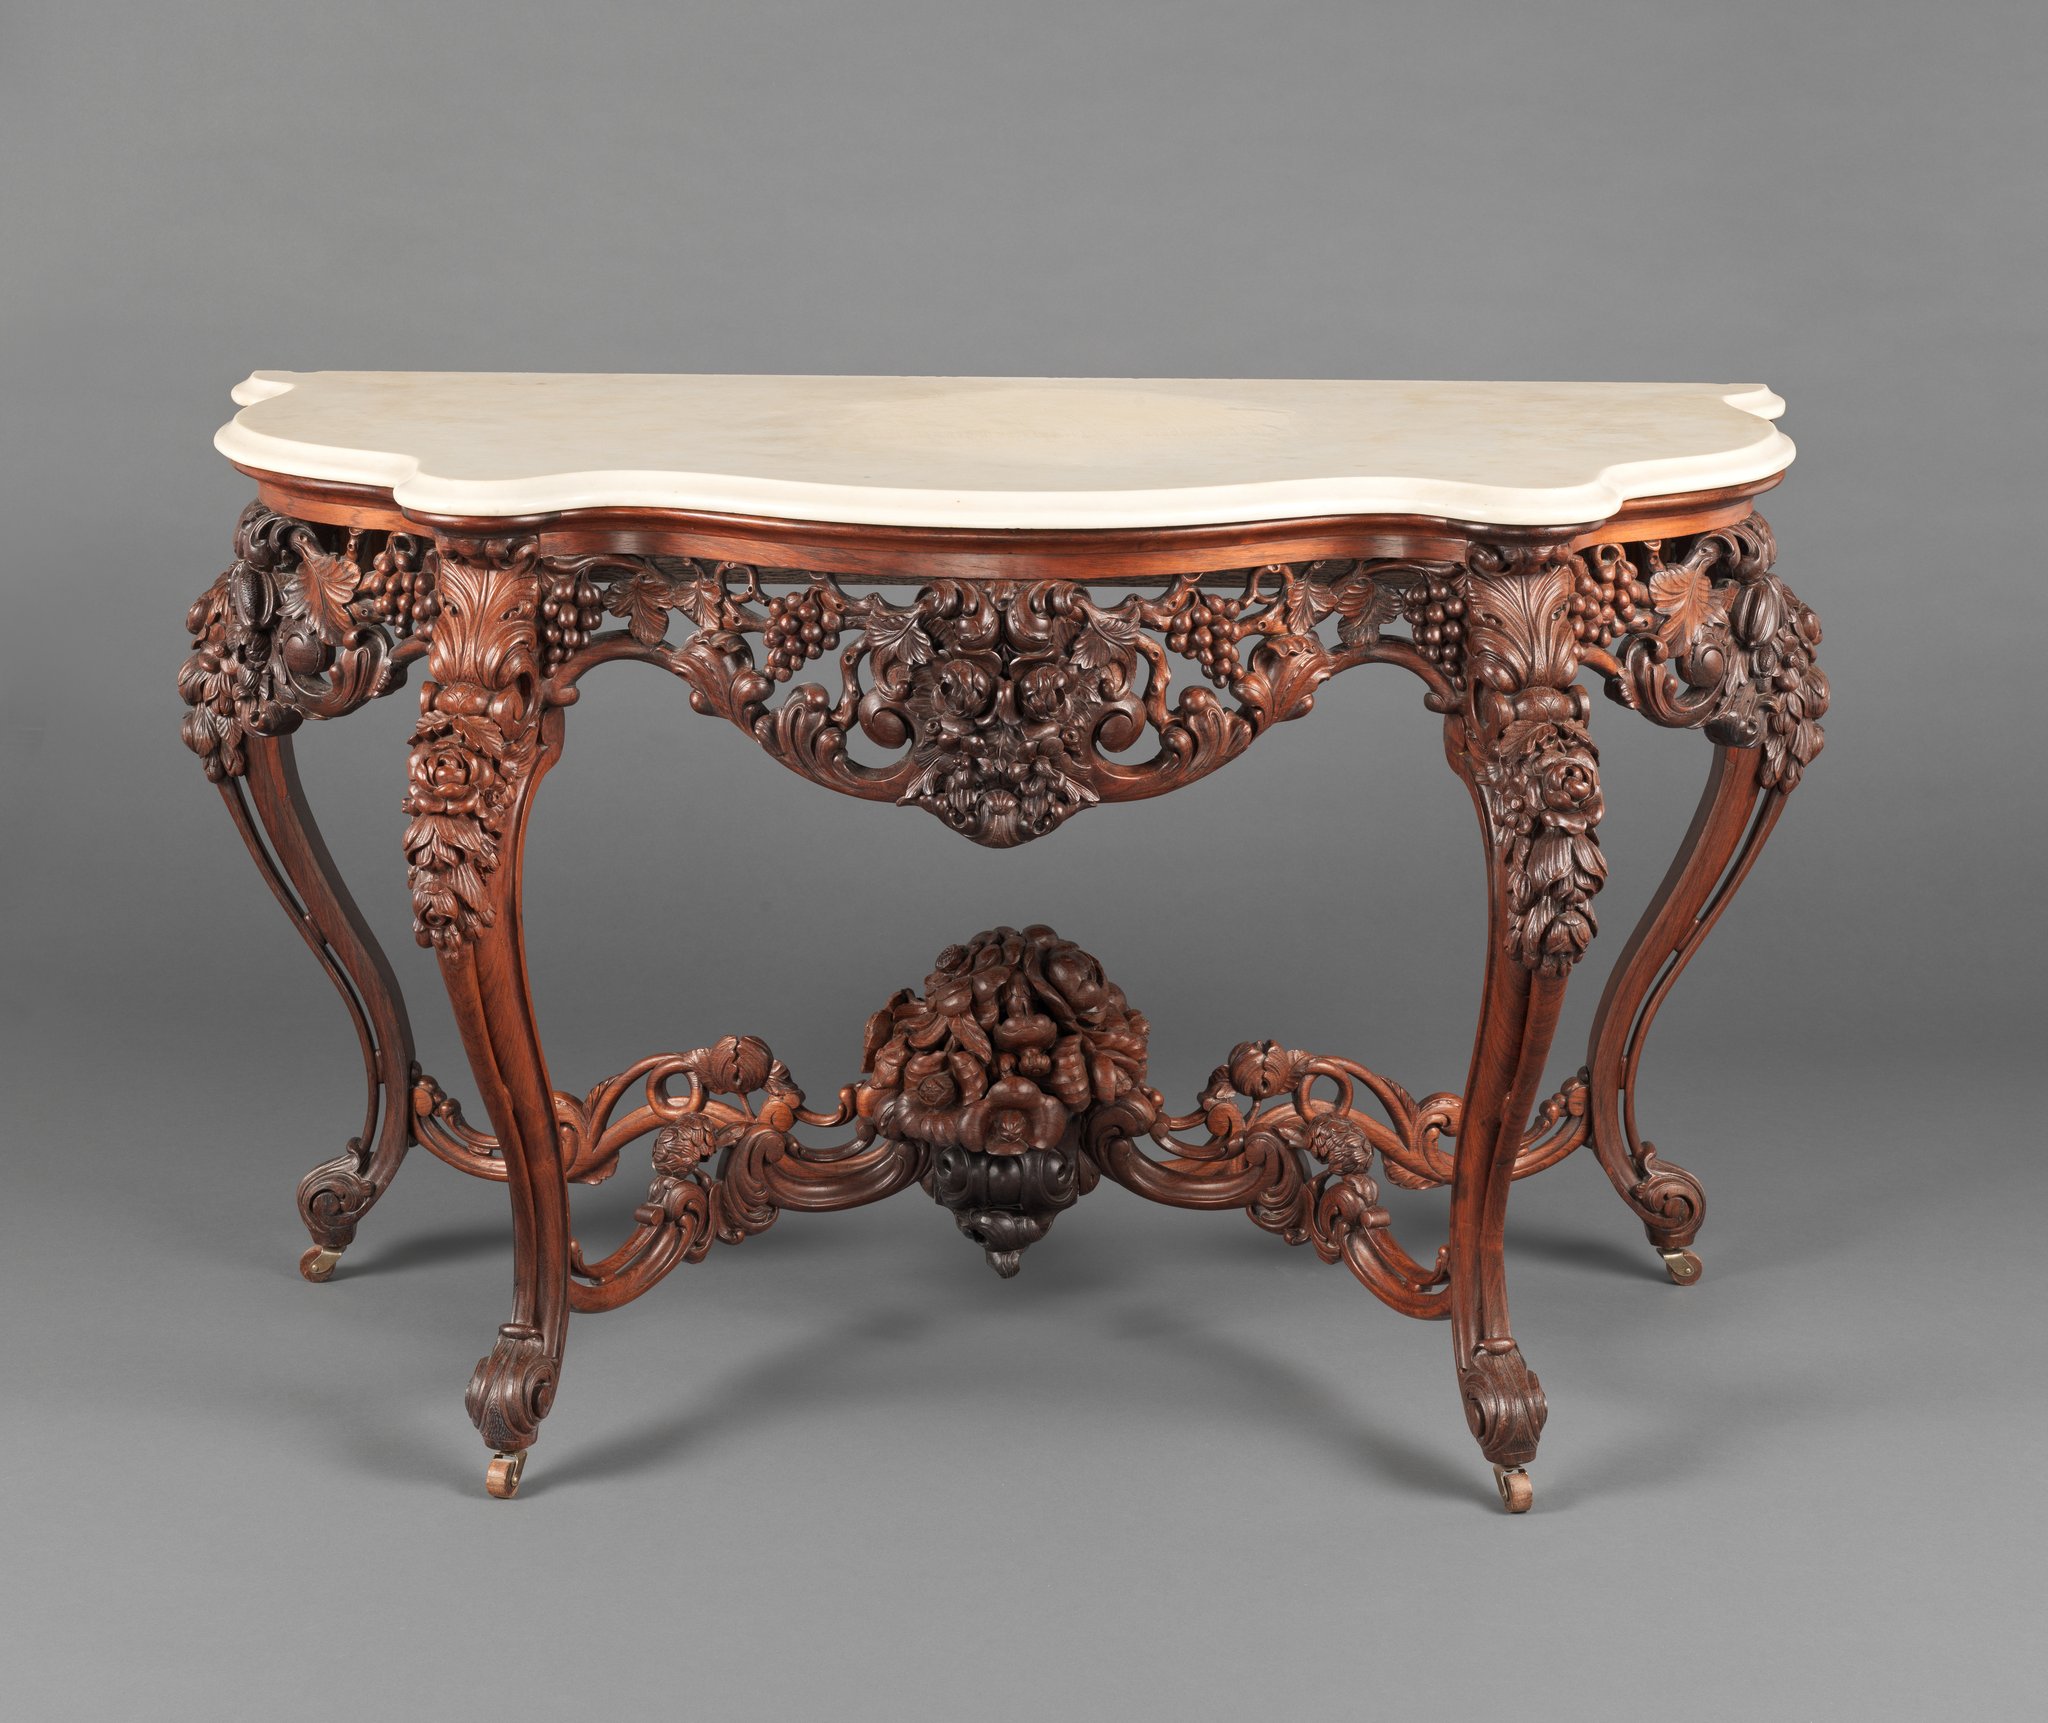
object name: console table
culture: american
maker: john henry belter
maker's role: maker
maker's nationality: american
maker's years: 1804-1863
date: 1850-1860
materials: marble, wood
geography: united states